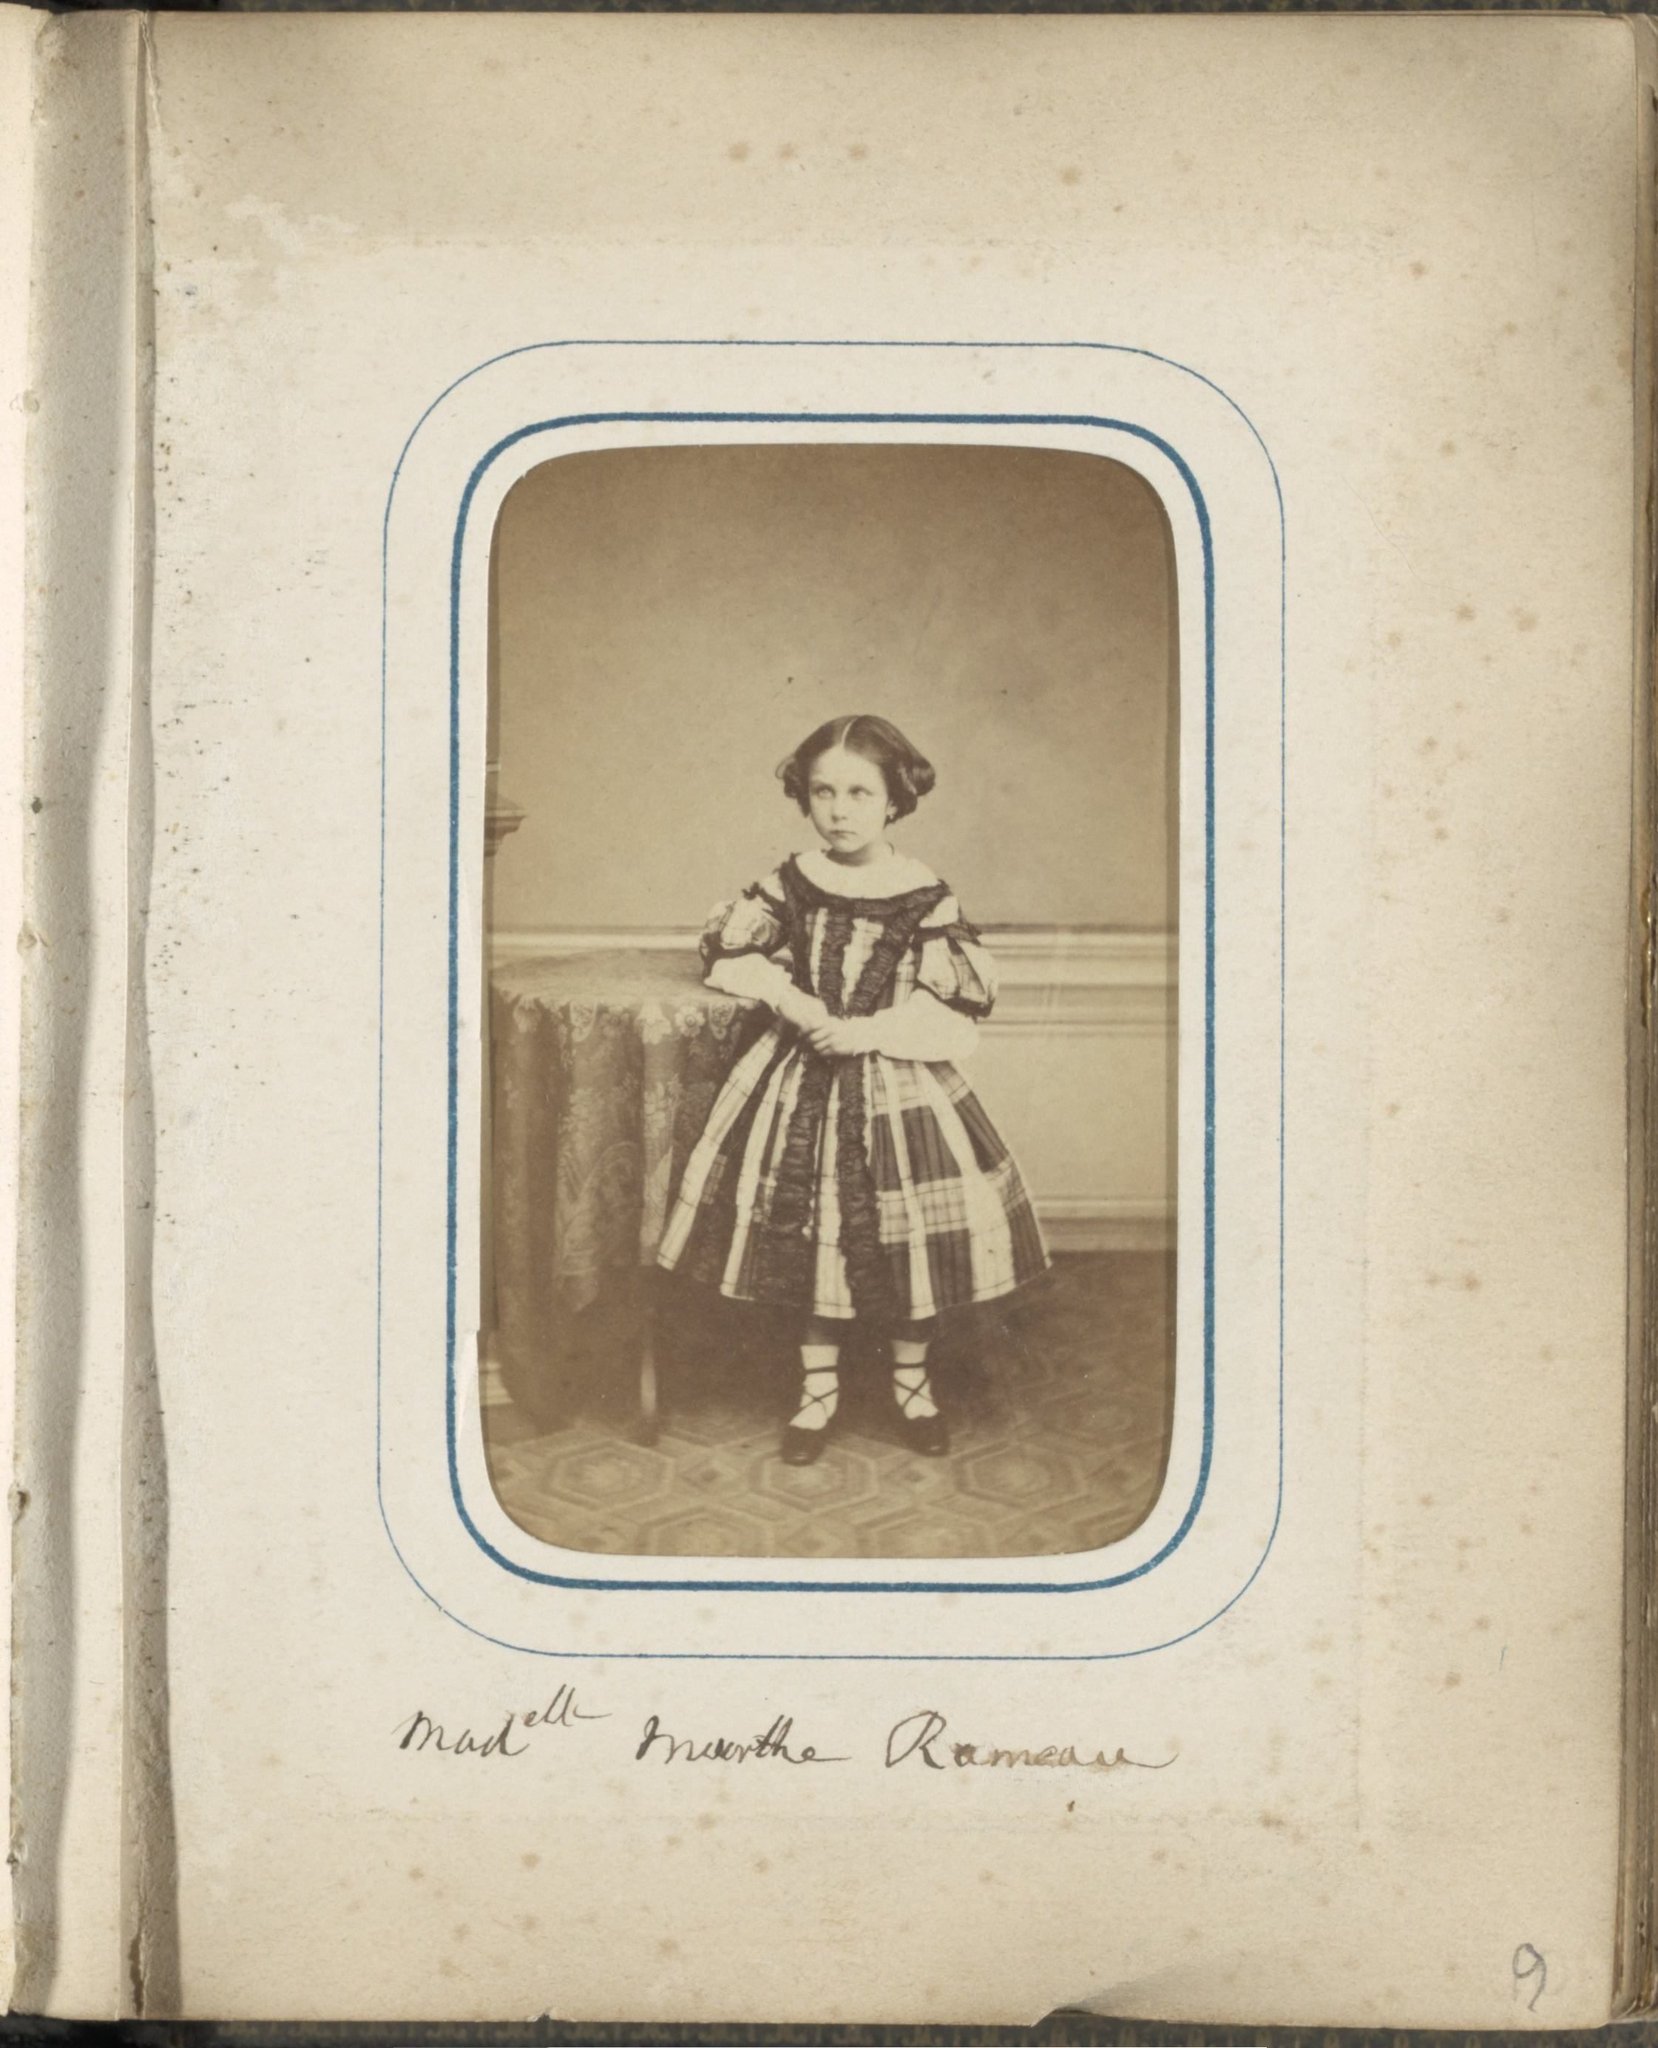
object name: photograph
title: Portret van Marthe Rameau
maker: vuagnat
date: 1860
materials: cardboard, paper, photographic support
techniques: albumen print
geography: lyon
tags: studio requisites ~ photographer, child, historical persons, styles of hairdress - aa - ~ women, shoes, sandals, dress, gown, lyon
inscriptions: address: ‘Lyon’, name: ‘Vuagnat peintre photographe’, date: ‘18 Septembre 1860’, name: ‘Mad.elle Marthe Rameau’, address: ‘Genève’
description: Onderdeel van Fotoalbum met 24 cartes-de-visite van Franse personen.